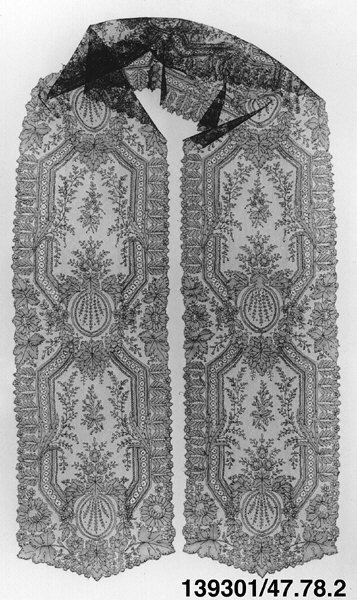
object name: scarf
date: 1870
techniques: lace